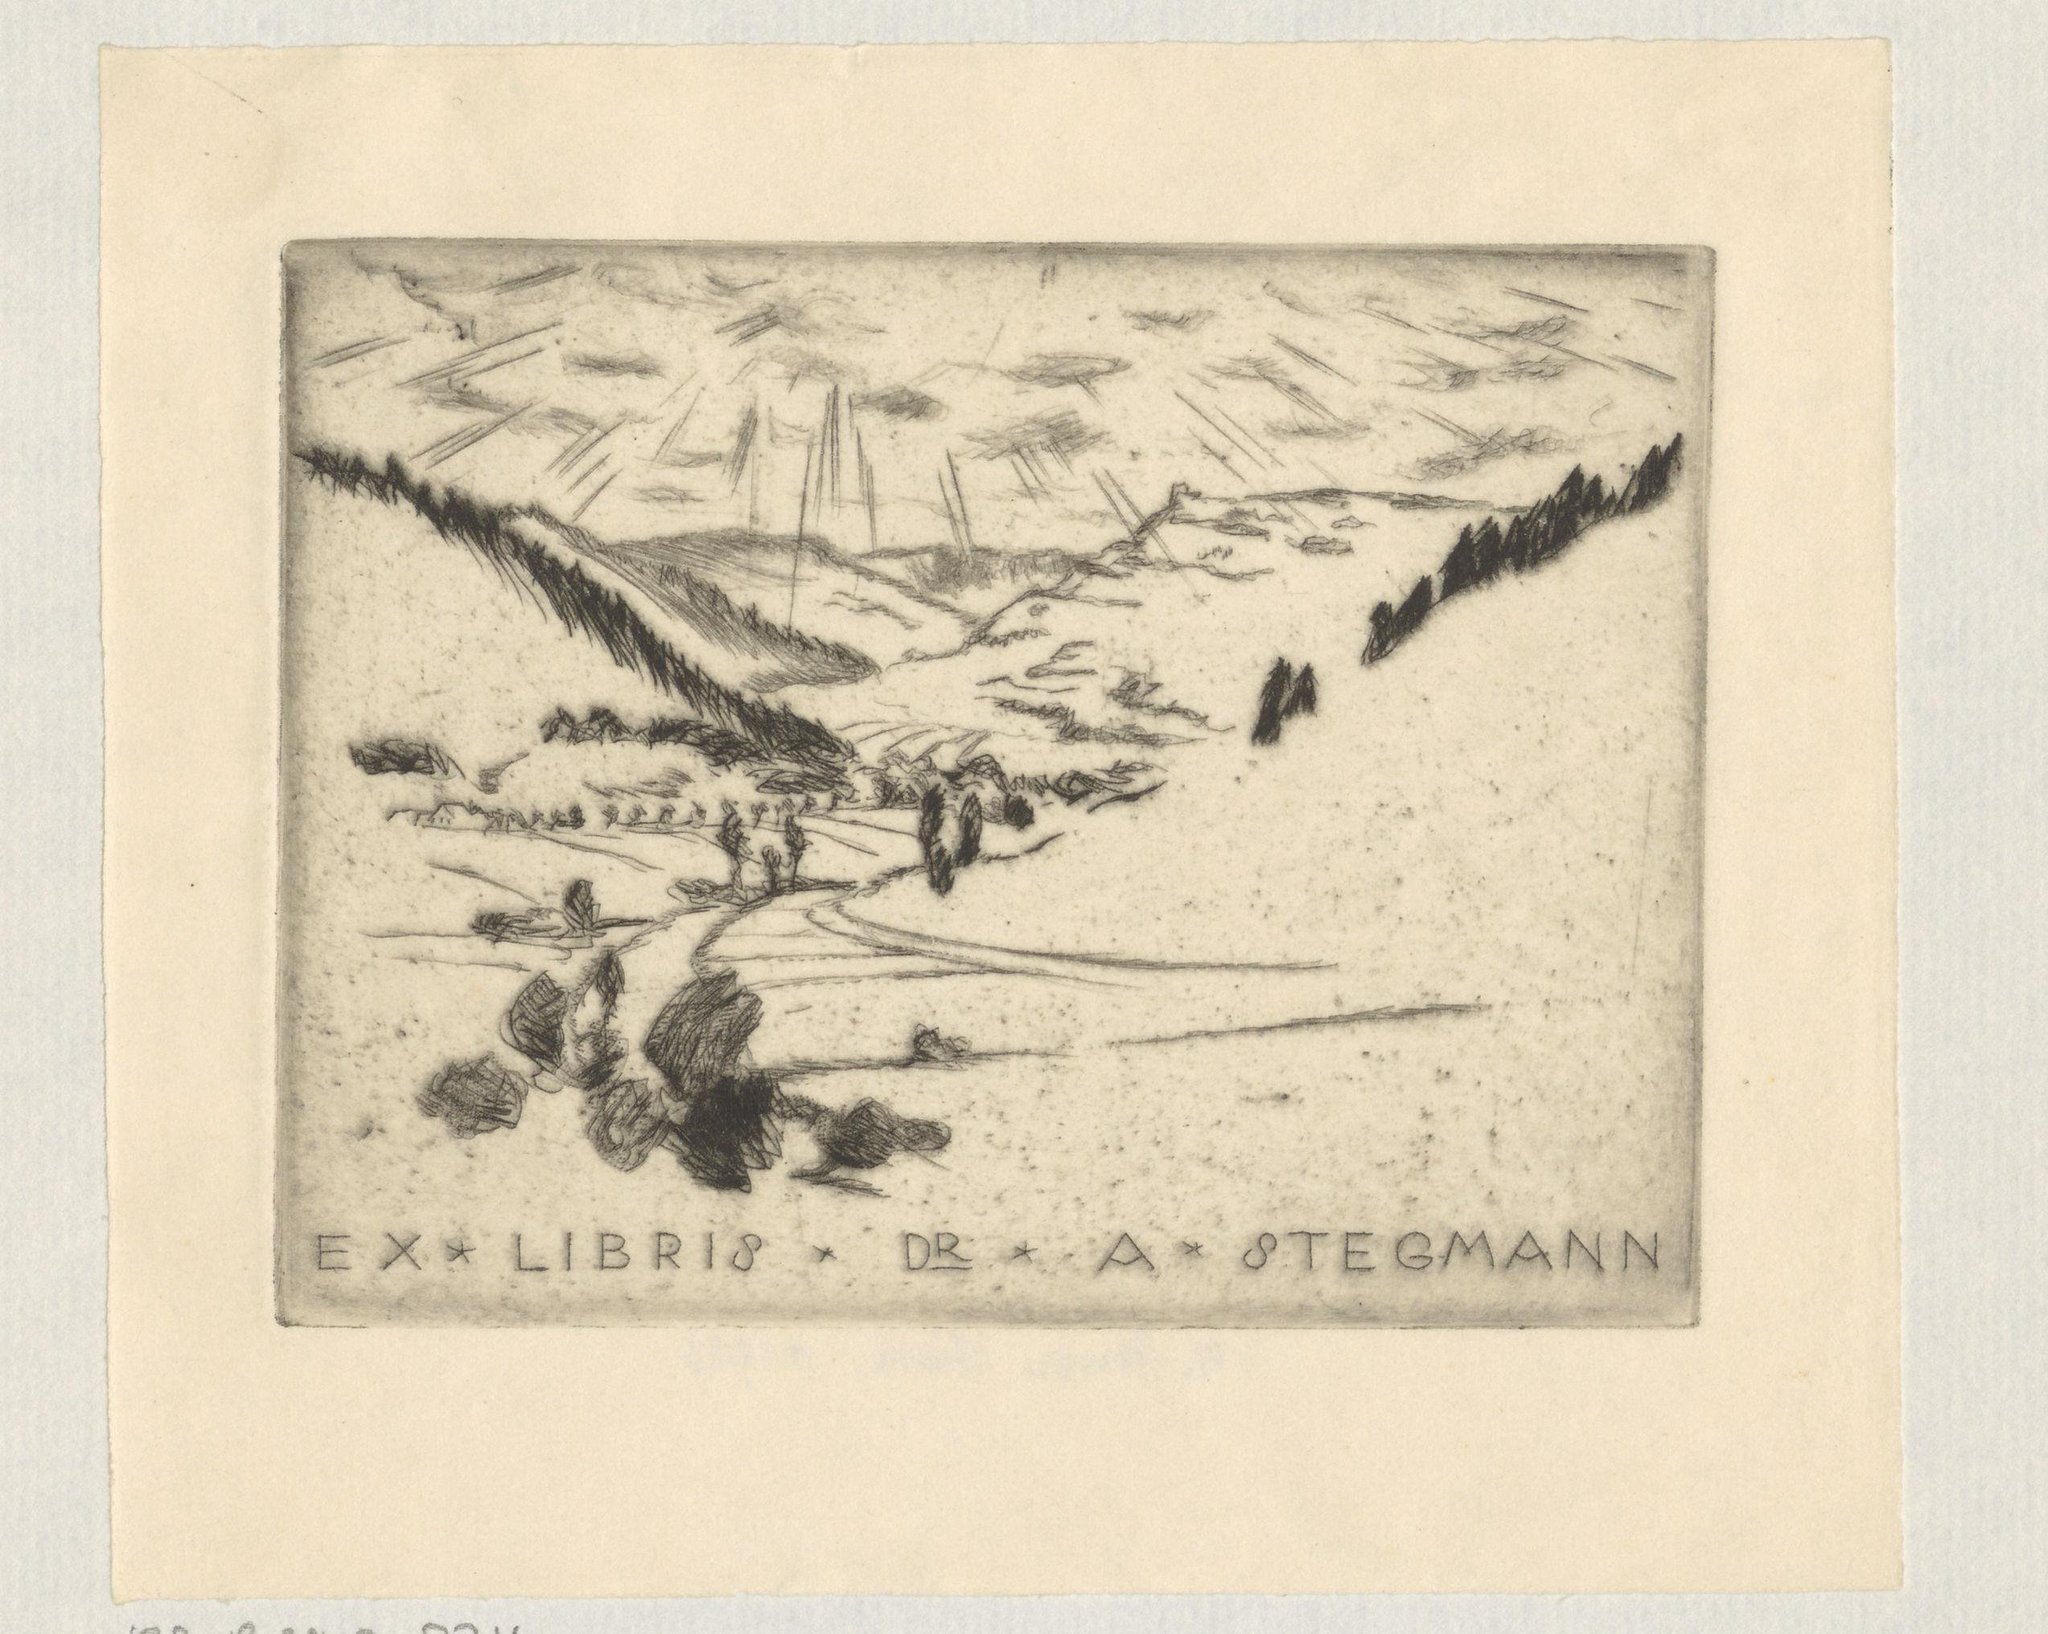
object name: bookplate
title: Ex libris van A. Stegmann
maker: wilhelm sauer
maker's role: print maker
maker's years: 1892-1930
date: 1924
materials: paper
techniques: etching, intaglio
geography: austria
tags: landscapes